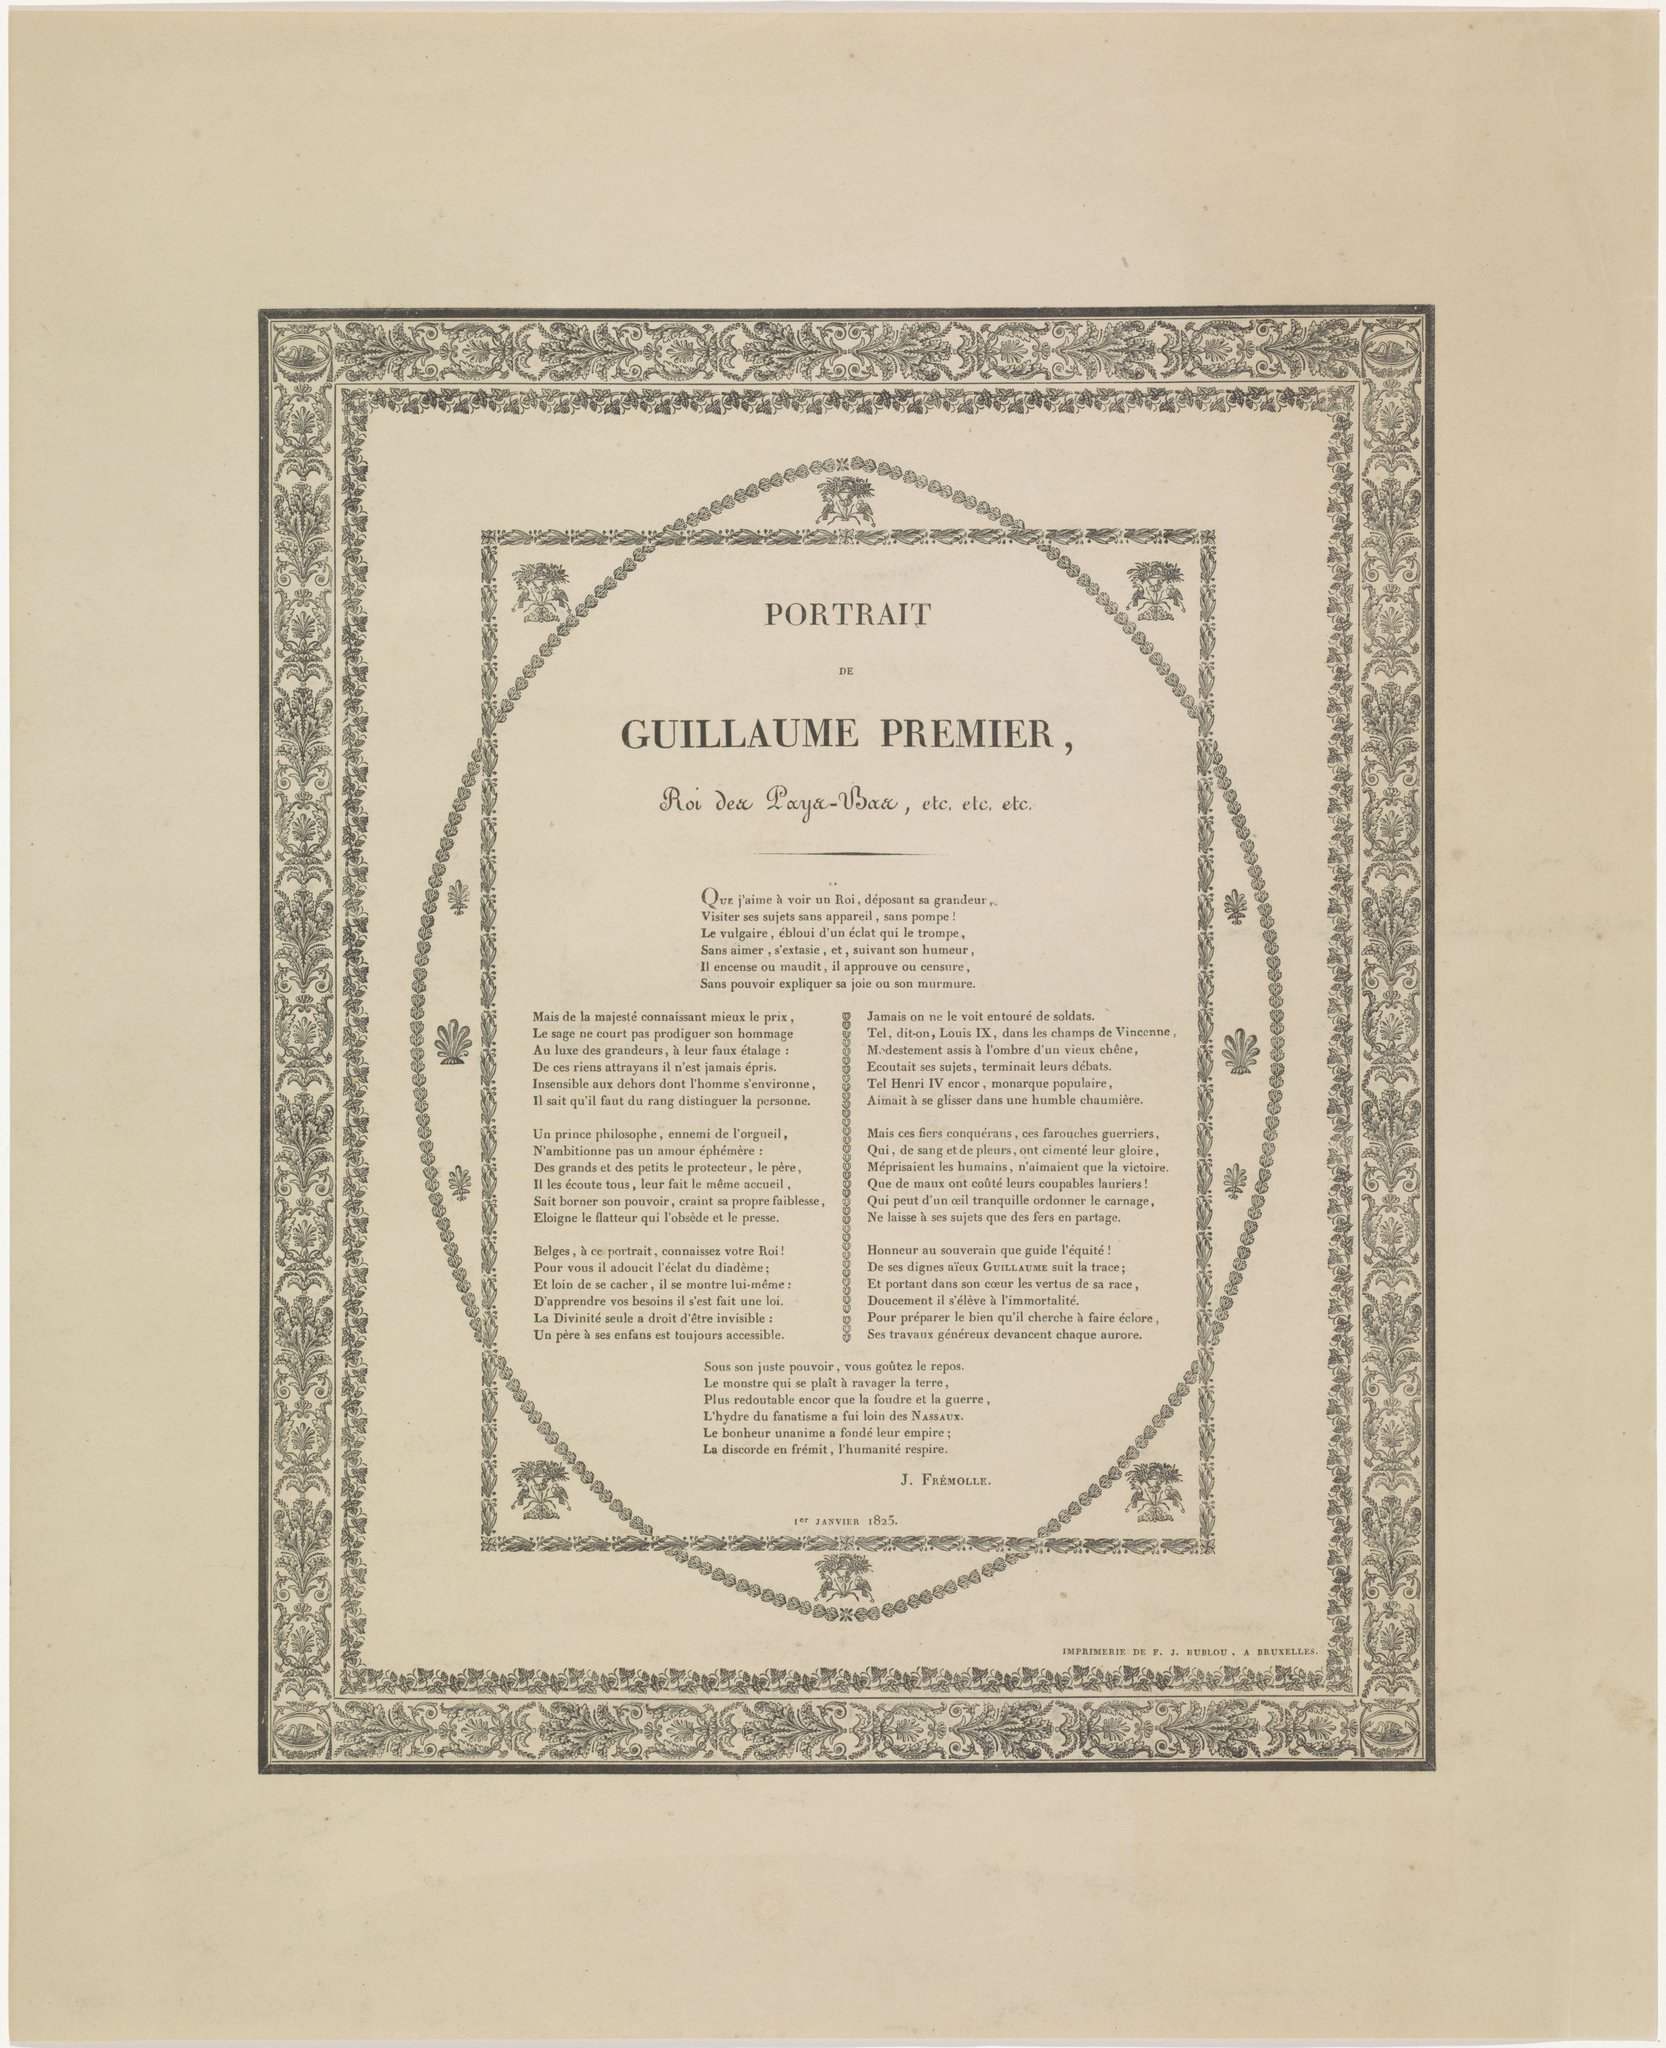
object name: text sheet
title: Tekst bij het portret van Willem I Frederik, koning der Nederlanden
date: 1825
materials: paper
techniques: letterpress printing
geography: brussels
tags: the hague, william i of the netherlands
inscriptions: collector's mark: Lugt 2228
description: De hier vermelde titel verwijst naar de hoogst verkregen titel van de geportretteerde, niet per se naar de titel die de geportretteerde op deze voorstelling draagt.